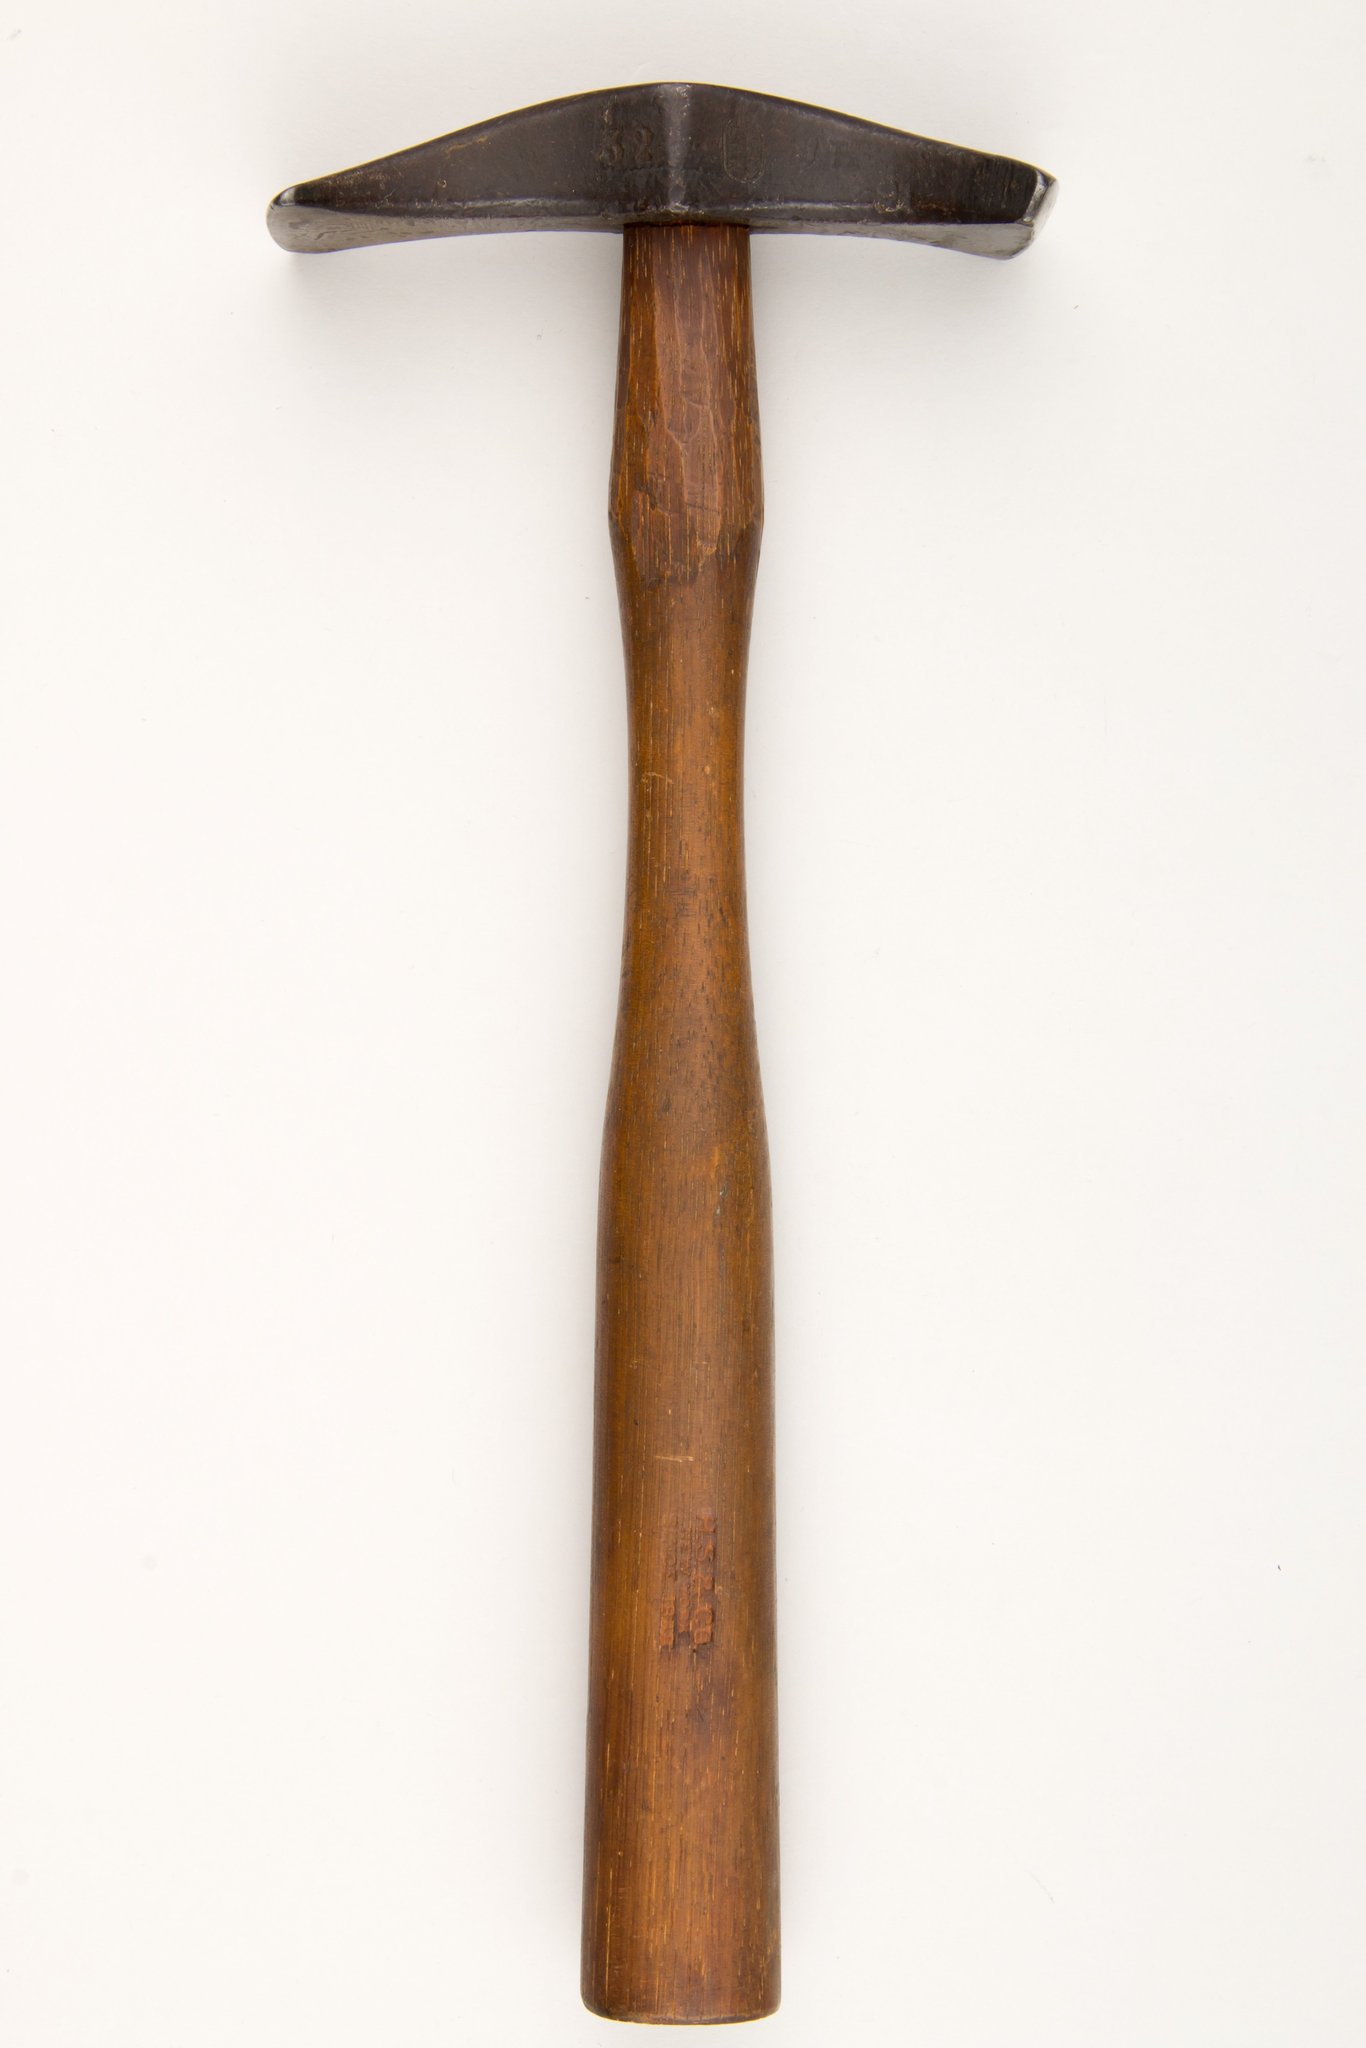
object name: armorer's hammer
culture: french or german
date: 1701-1900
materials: iron, wood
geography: germany